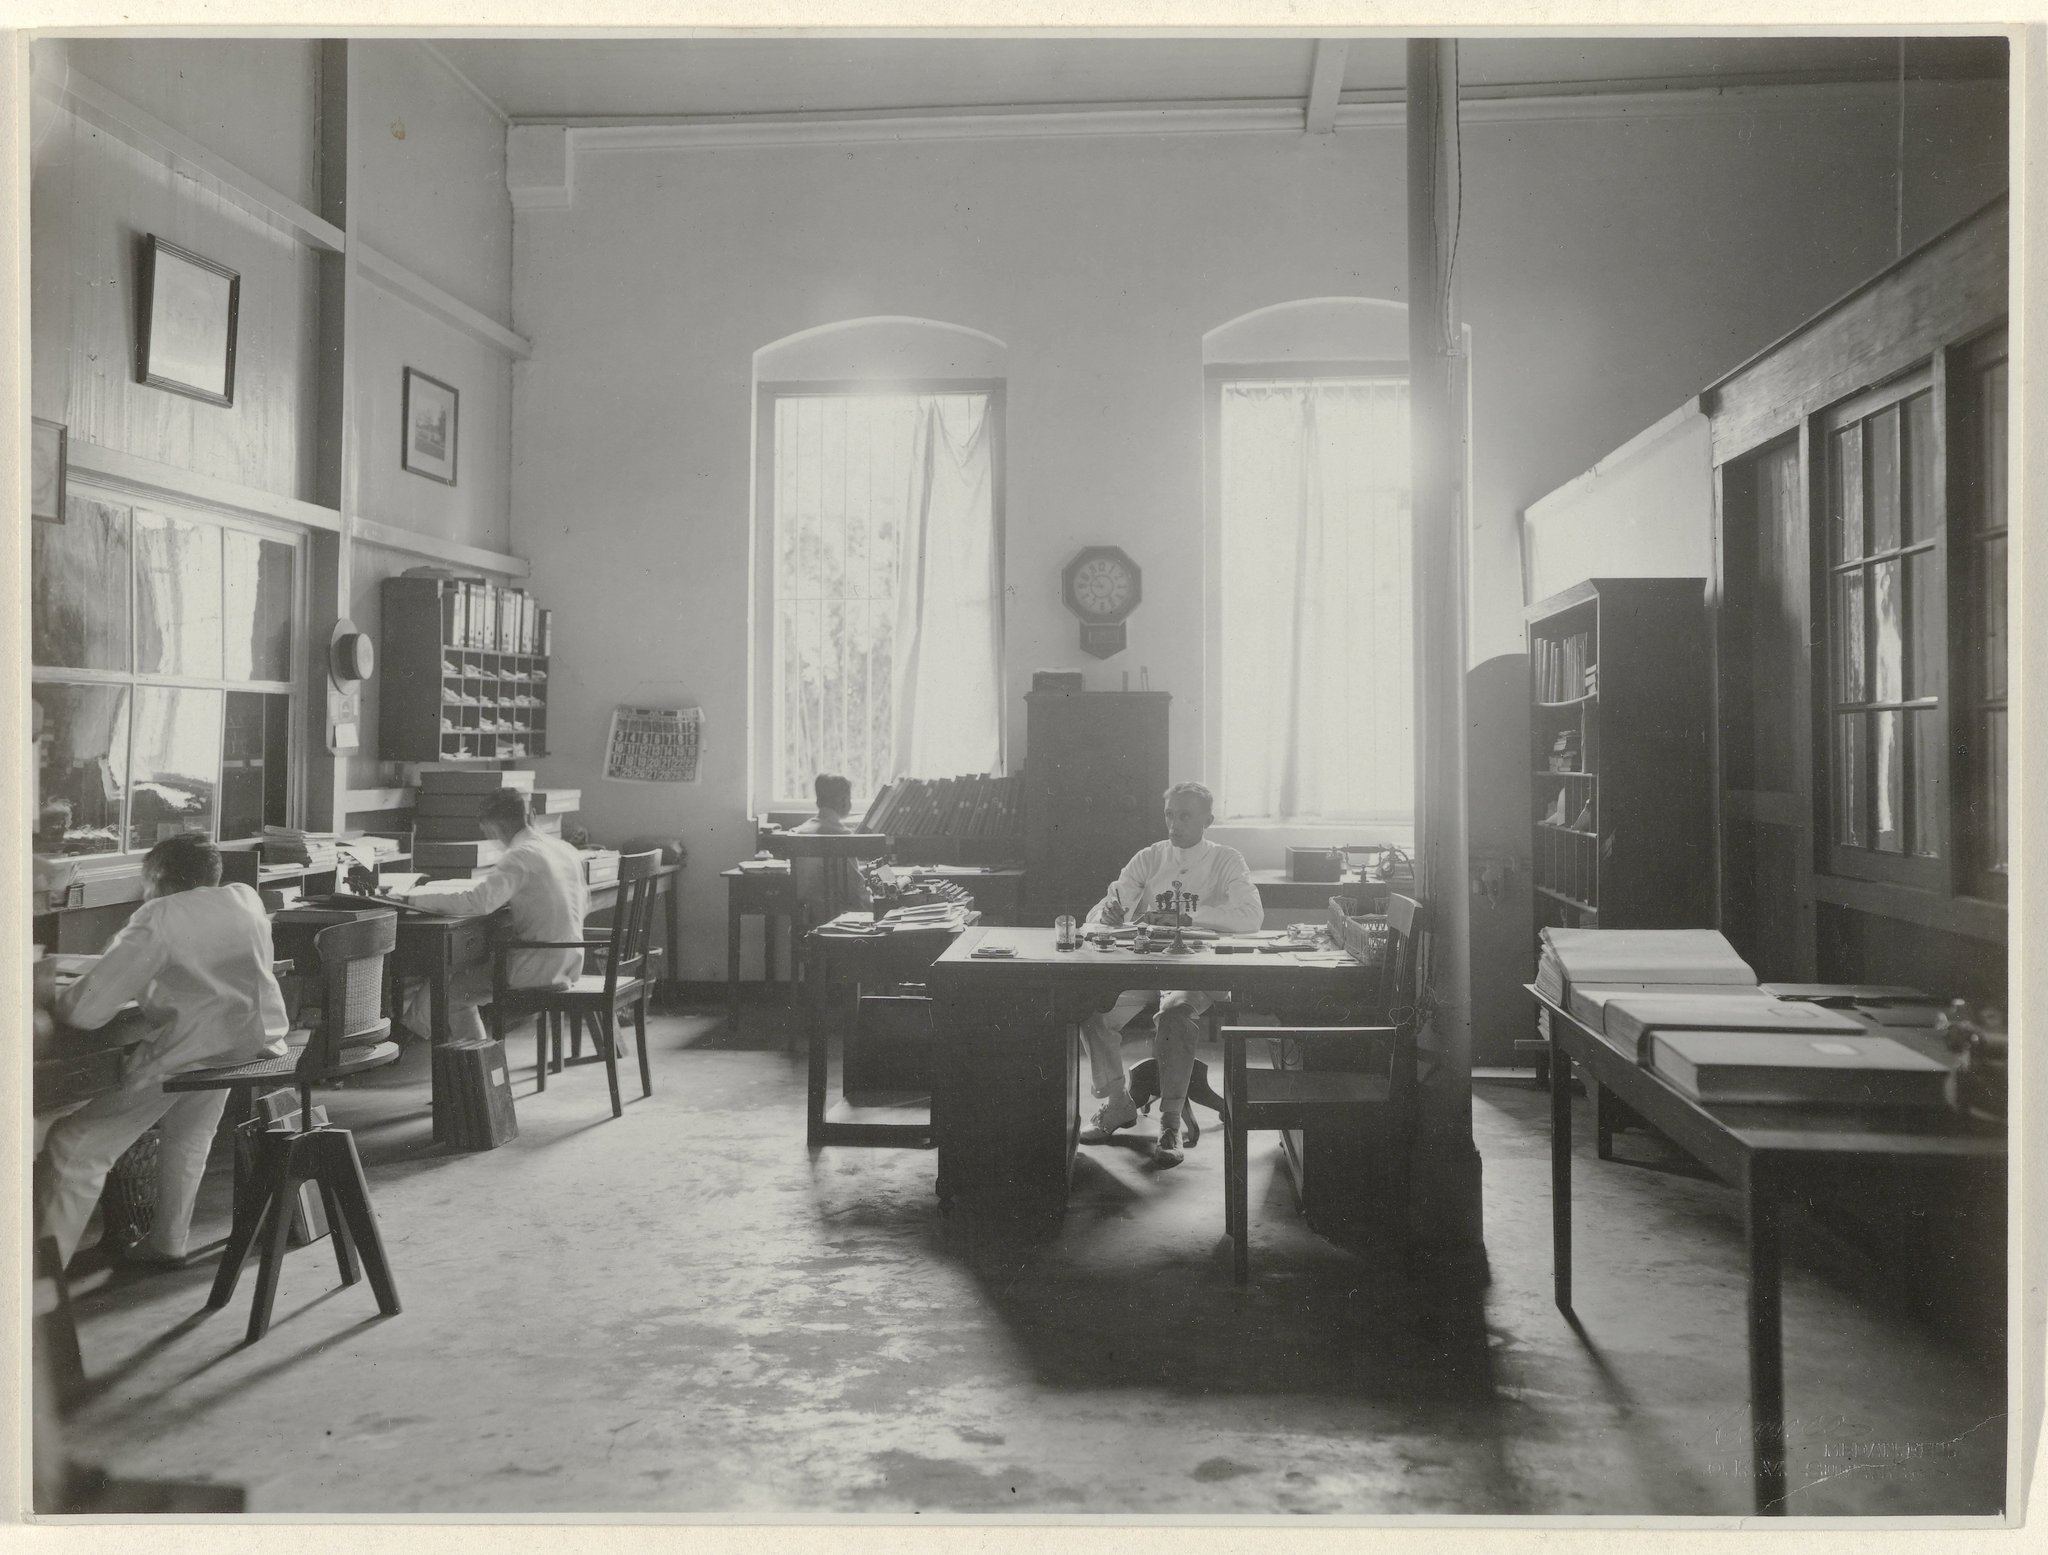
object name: photograph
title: Administratie van de drukkerij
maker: t. kaneo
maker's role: fotograaf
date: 1921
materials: photographic support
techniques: gelatin silver print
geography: medan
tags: dutch east indies, the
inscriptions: inscription: ‘Administratie’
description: Gezicht in het kantoor van de administratie van de drukkerij van de Deli Courant te Medan. Onderdeel van een groep van 18 foto's uit 1921 binnen de groep van 49 losse zwart-wit foto's van verschillend formaat over de uitgeverij en drukkerij van de krant Deli Courant in Medan in de periode 1885-1947.